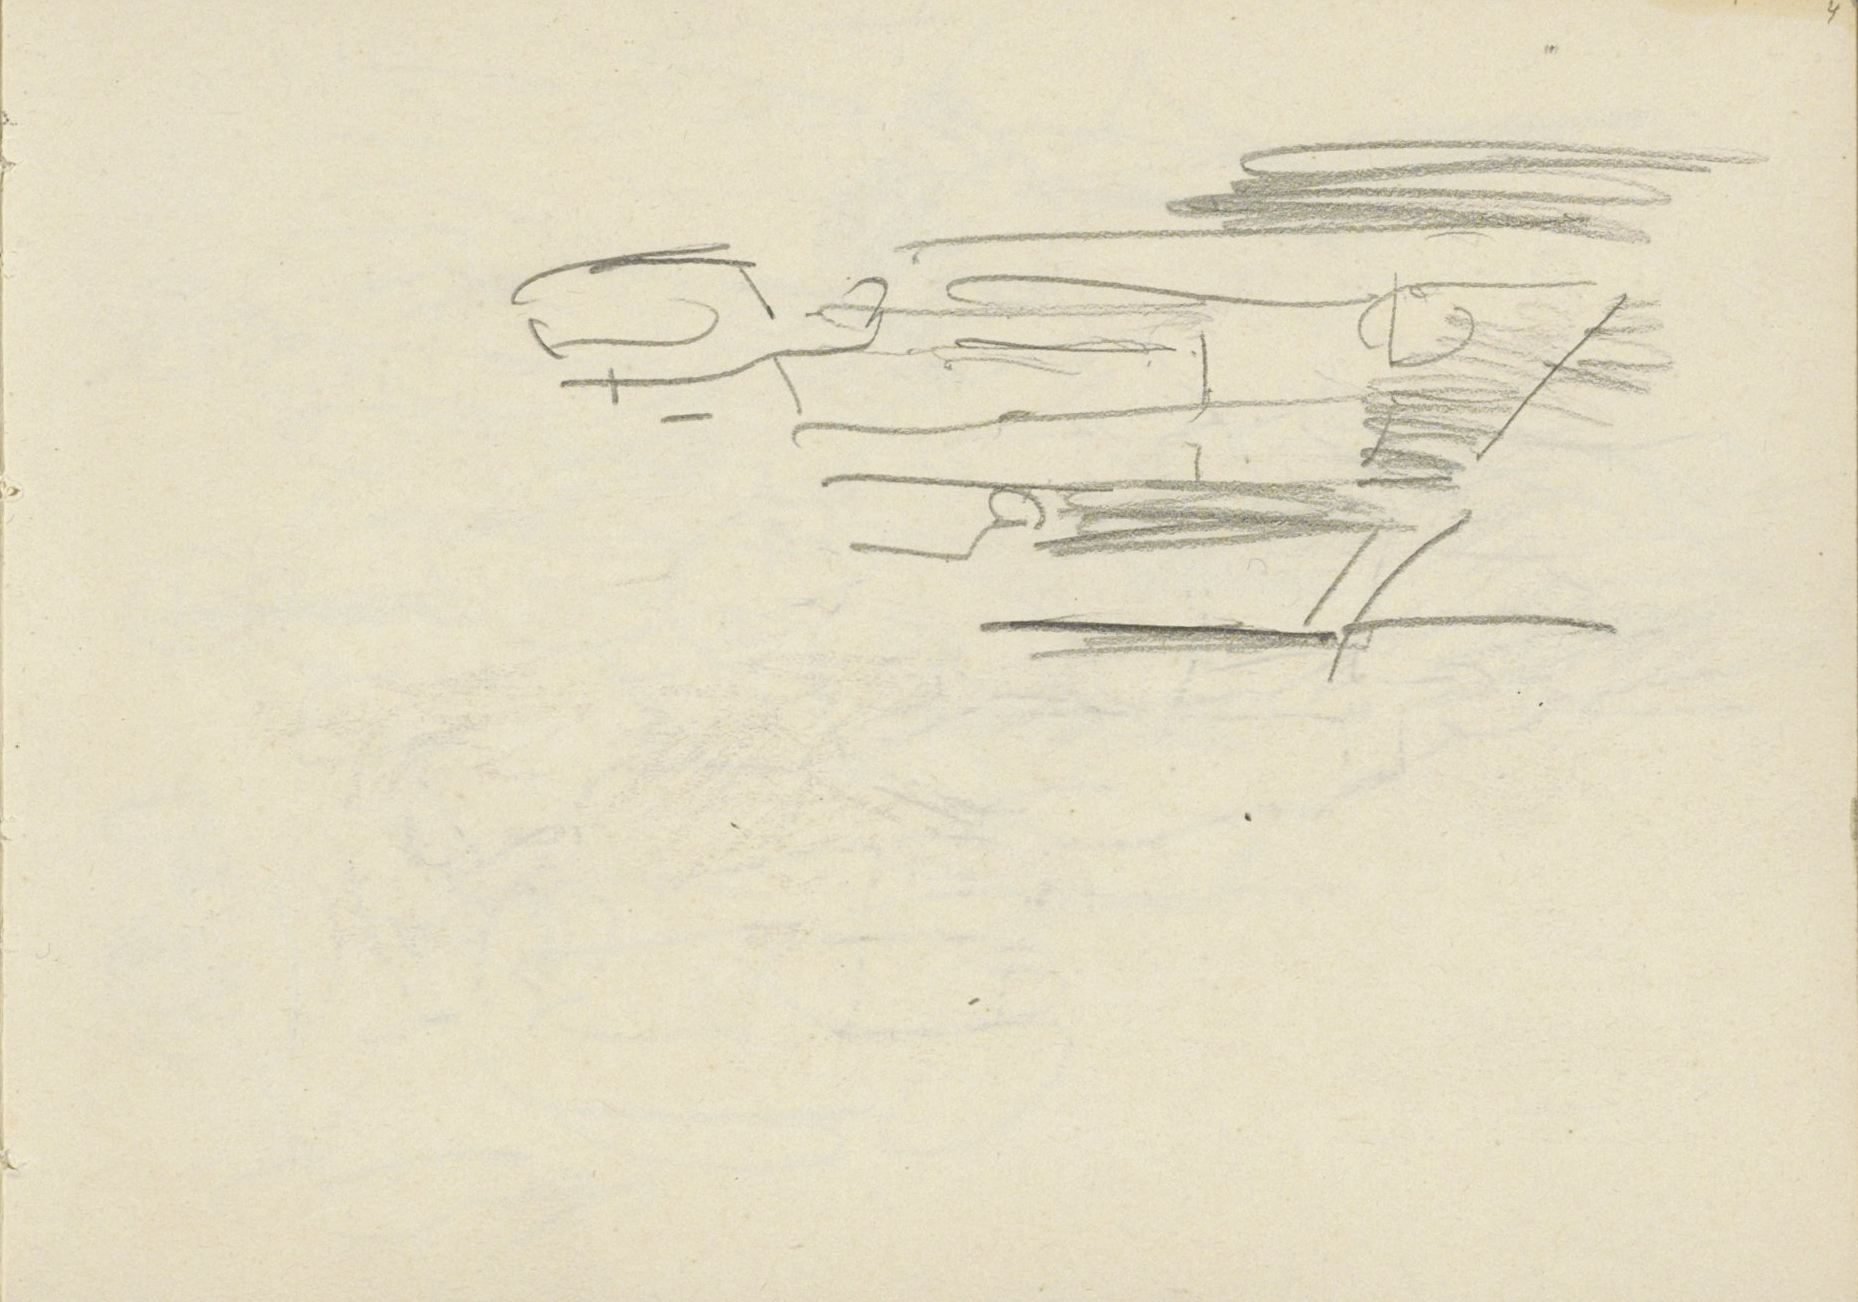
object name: sketchbook leaf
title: Figuren voor gebouwen, mogelijk winkels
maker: isaac israels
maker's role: draughtsman, painter, print maker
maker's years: 1865-1934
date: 1930-1934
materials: paper, pencil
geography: the hague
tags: shop, store, street (+ city(-scape) with figures, staffage)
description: Pagina 4 uit schetsboek XXXVIII met 45 pagina's.